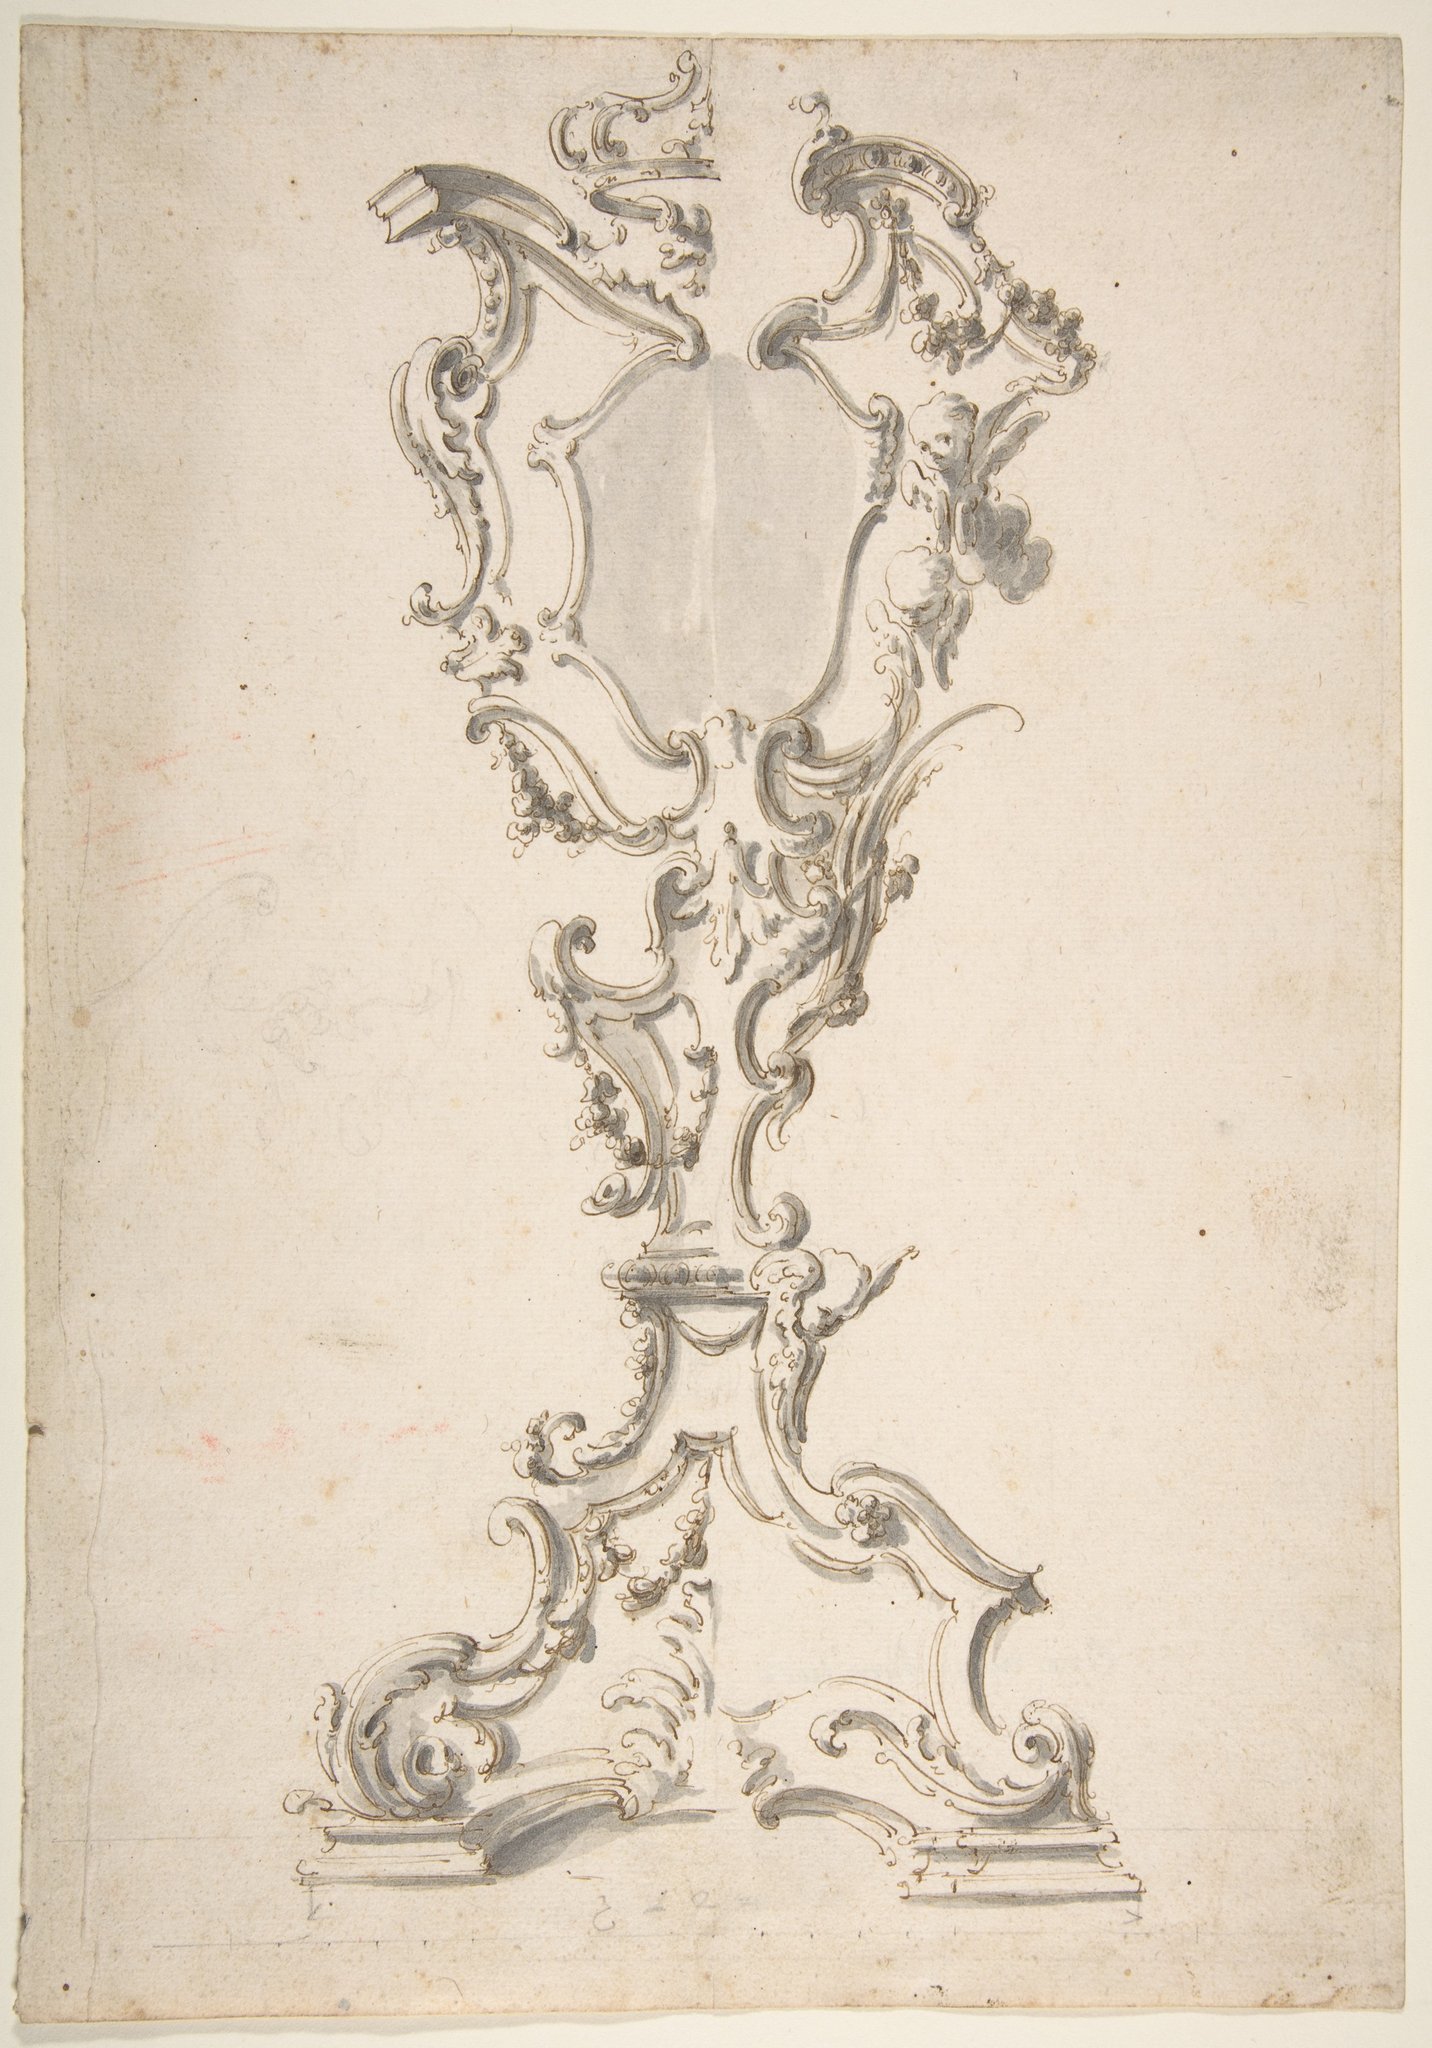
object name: drawing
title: Two Alternative Designs for a Mirror Stand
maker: giovanni battista natali iii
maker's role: artist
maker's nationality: italian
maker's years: 1698-1765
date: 1698-1765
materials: chalk, graphite, ink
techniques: brush, pen, wash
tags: mirrors